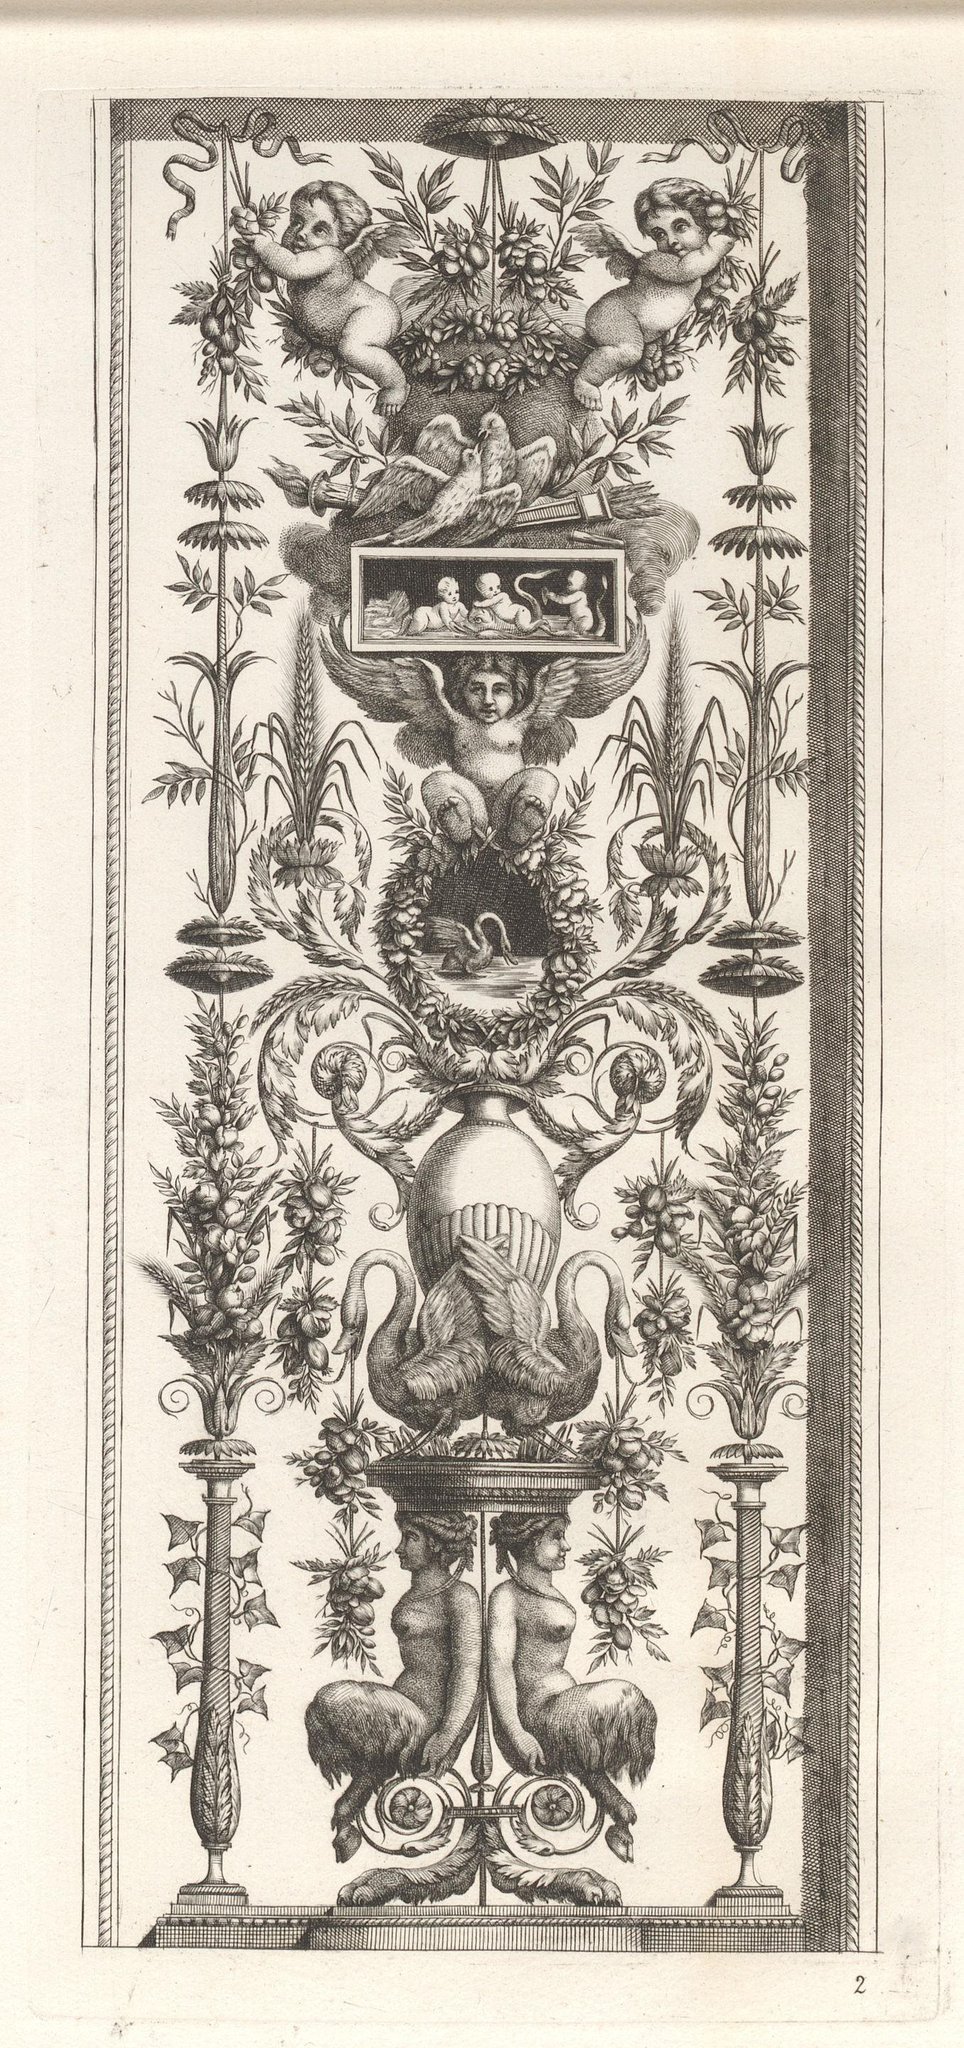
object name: ornament print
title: Ornament met zwanen, vrouwelijke satyrs en putti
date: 1802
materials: paper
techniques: engraving, etching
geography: paris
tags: ornament ~ arabesque, satyr(s) (in general) - ll - female satyrs (in general), water-birds: swan, cupids: 'amores', 'amoretti', 'putti', ornament derived from plant forms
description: Doordat dit album bestaat uit meerdere, deels eerder uitgegeven prentreeksen, is de datering niet consequent. Het geheel is op de titelpagina gedateerd op 1802. Deze reeks is niet afzonderlijk gedateerd. De serietitel voor het gehele werk is "Recueil d'arabesques, contenant les loges du Vatican". De andere serietitel is de titel van de specifieke reeks binnen het geheel.